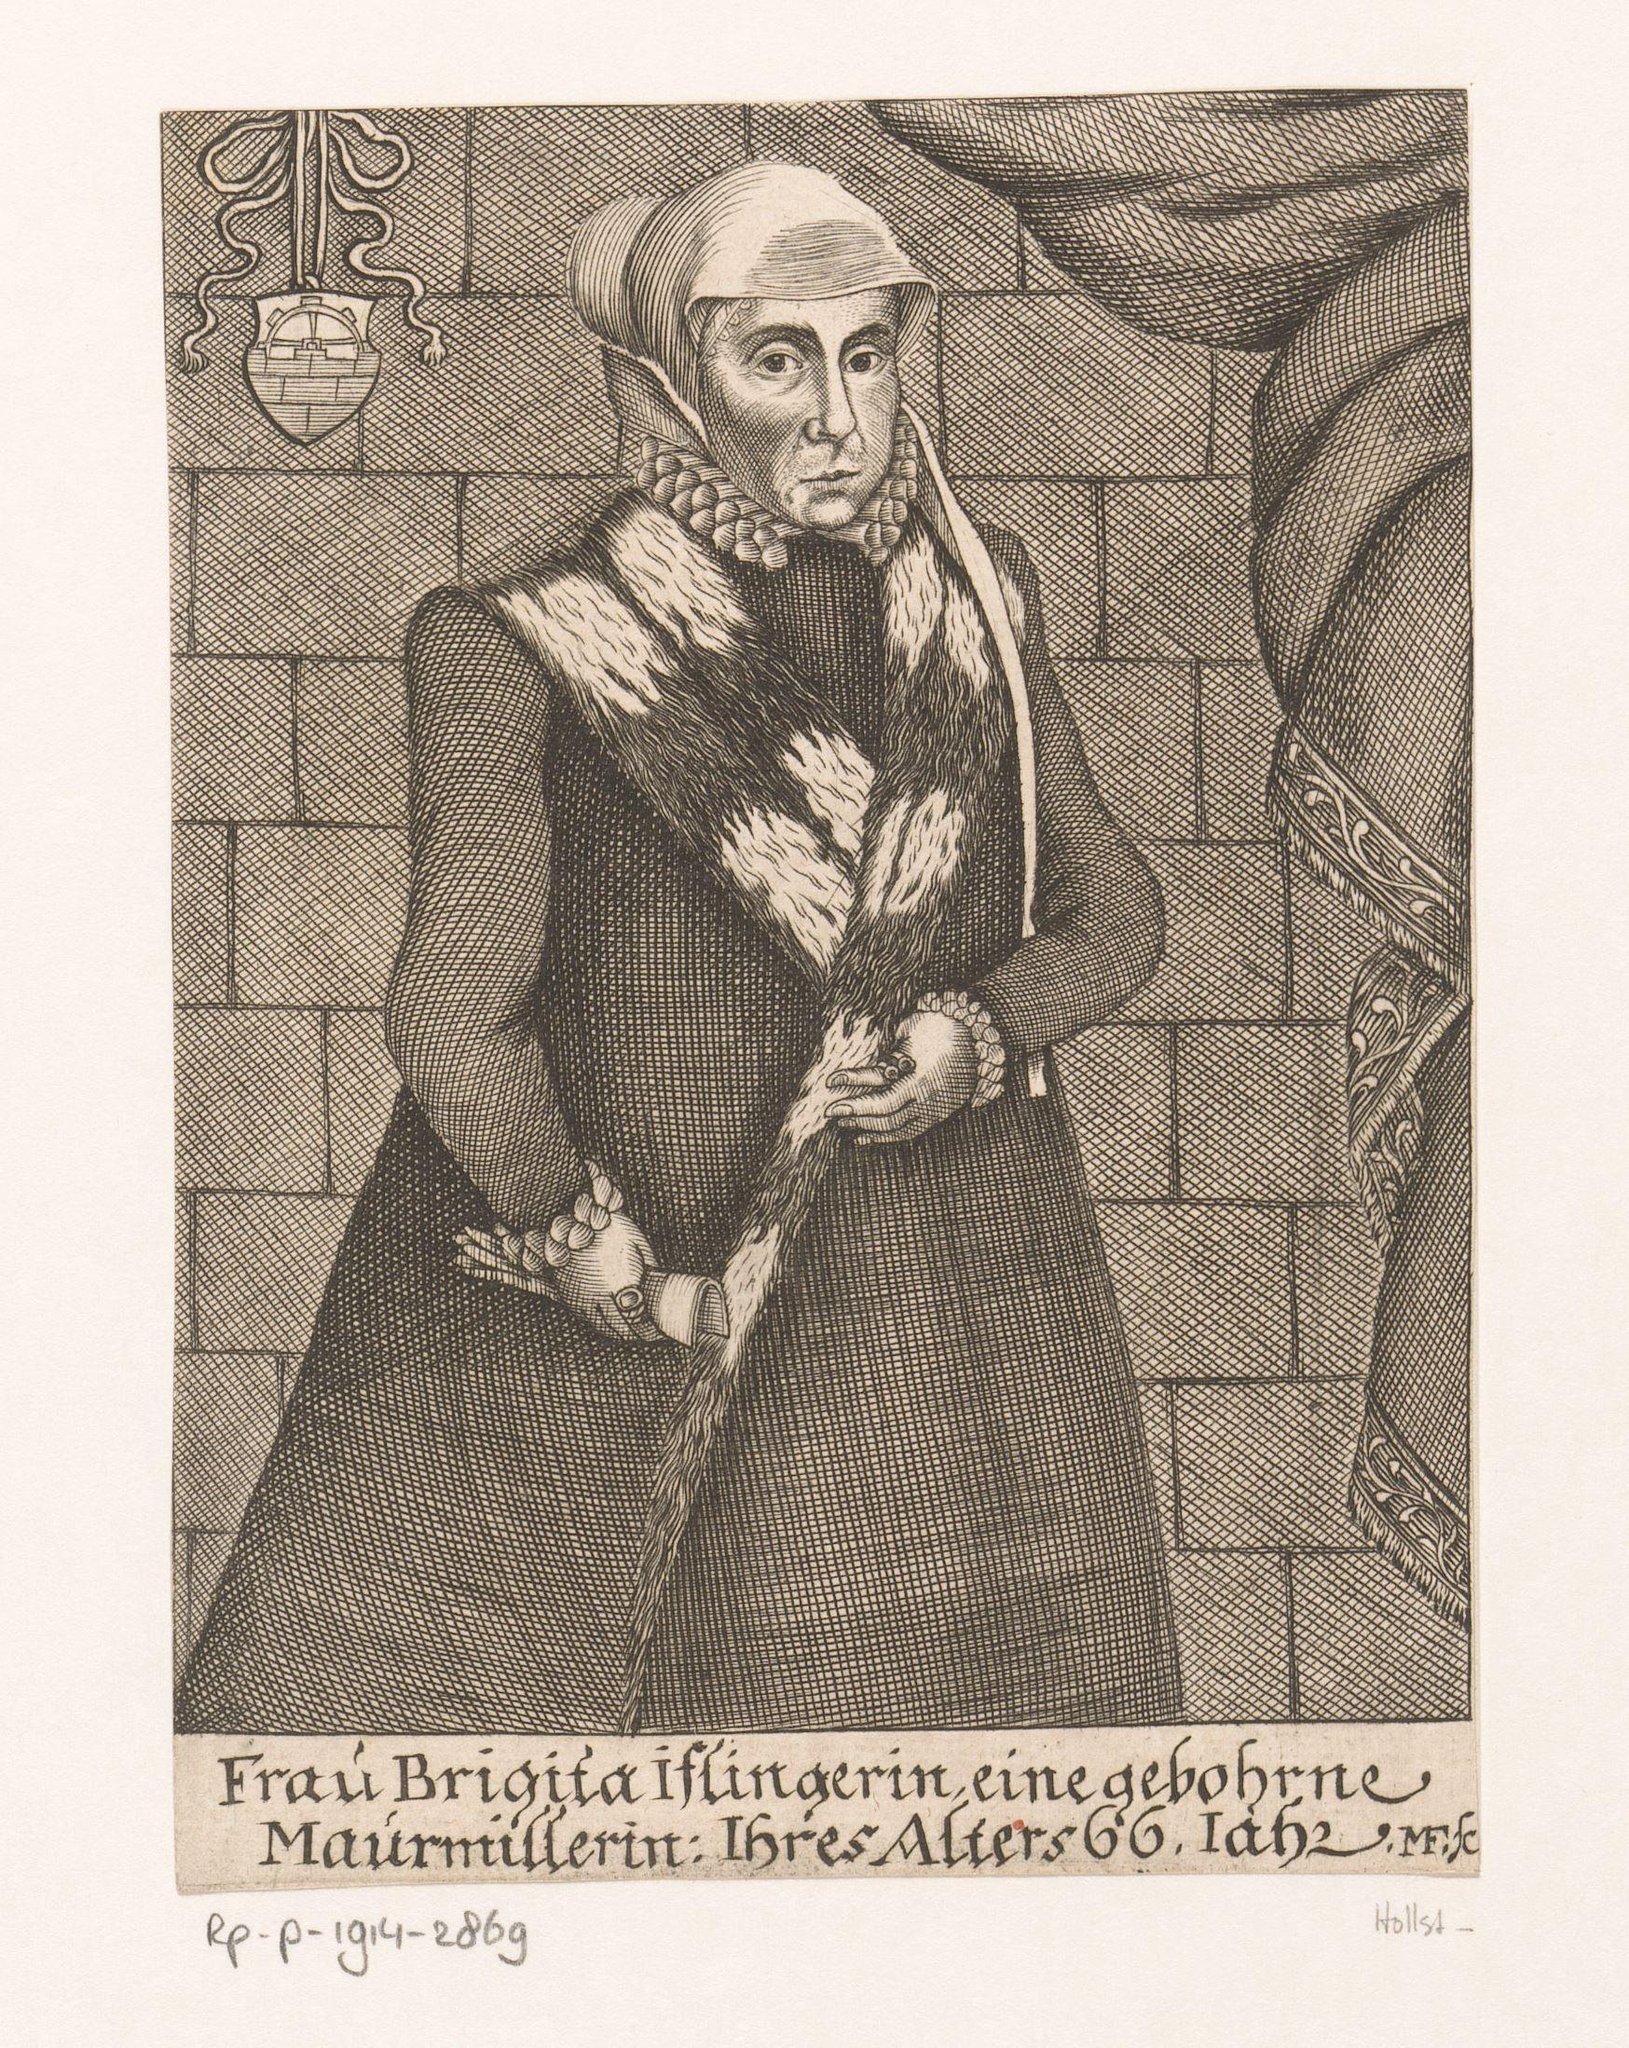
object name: print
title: Portret van Brigitta Iflinger op 66-jarige leeftijd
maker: michael fennitzer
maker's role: print maker, printer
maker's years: 1641-1702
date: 1651-1702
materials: paper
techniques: engraving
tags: historical persons - bb - woman, ring, writing and letters, armorial bearing, heraldry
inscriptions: collector's mark: Lugt 2228